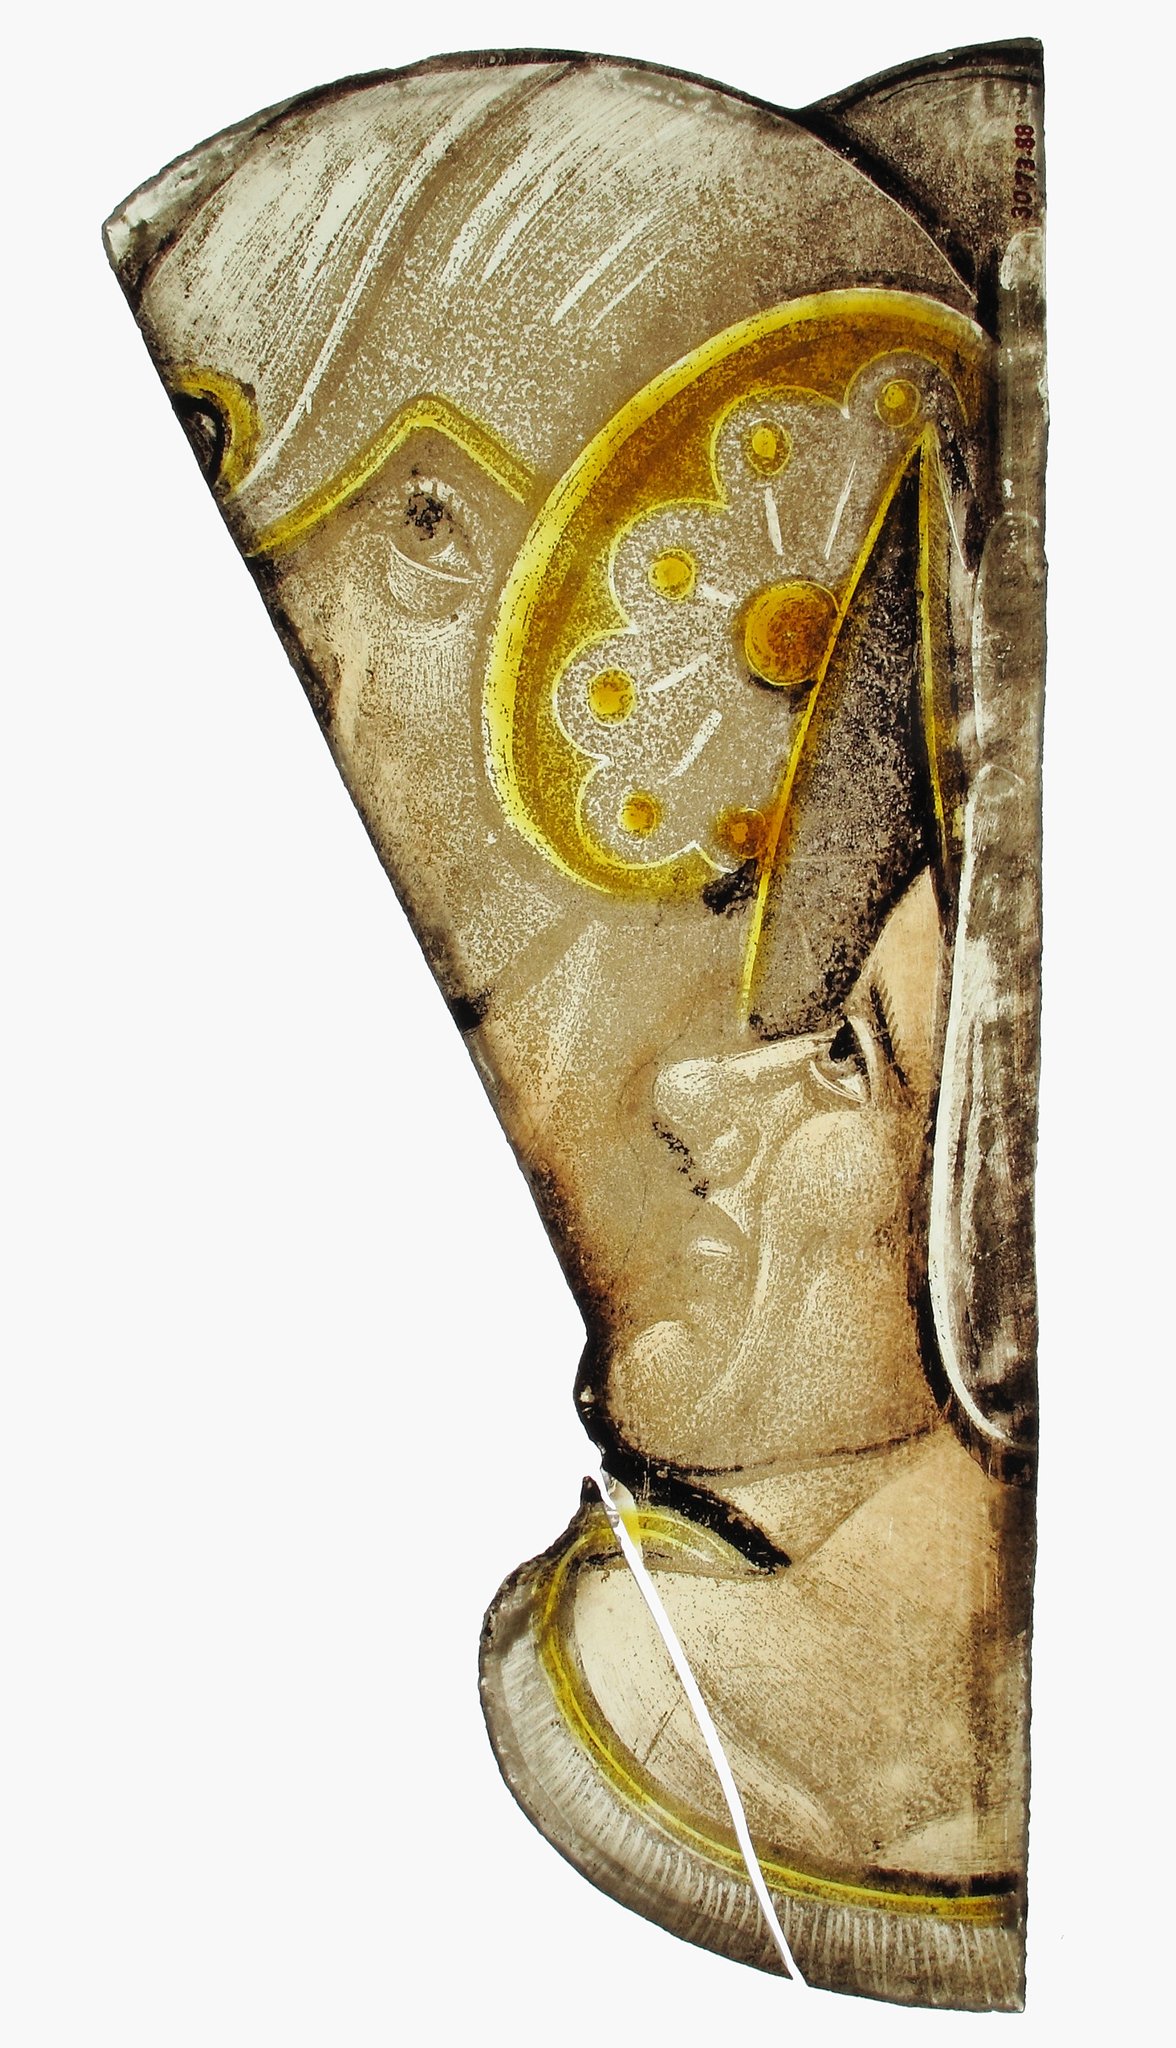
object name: fragment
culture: south netherlandish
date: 1501-1600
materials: glass, metal, paint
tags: men